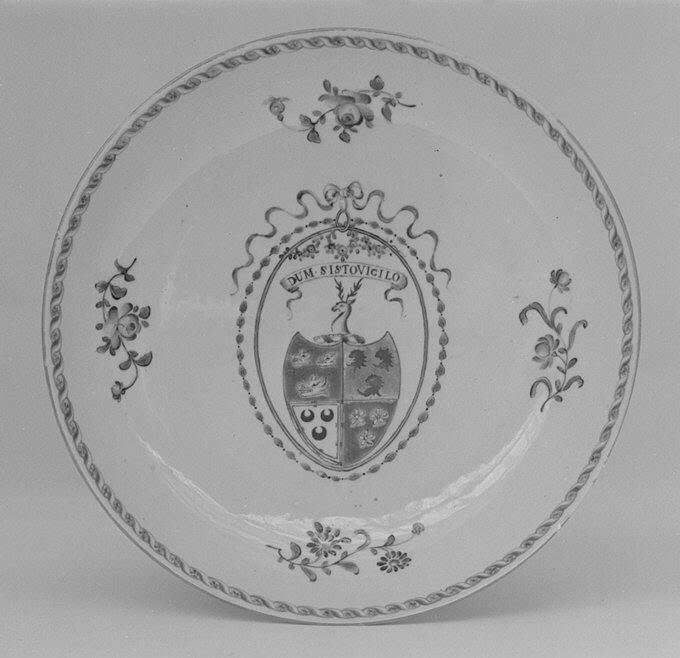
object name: soup plate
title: Soup plate (part of a service)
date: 1770-1785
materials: hard paste porcelain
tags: deer,flowers,coat of arms